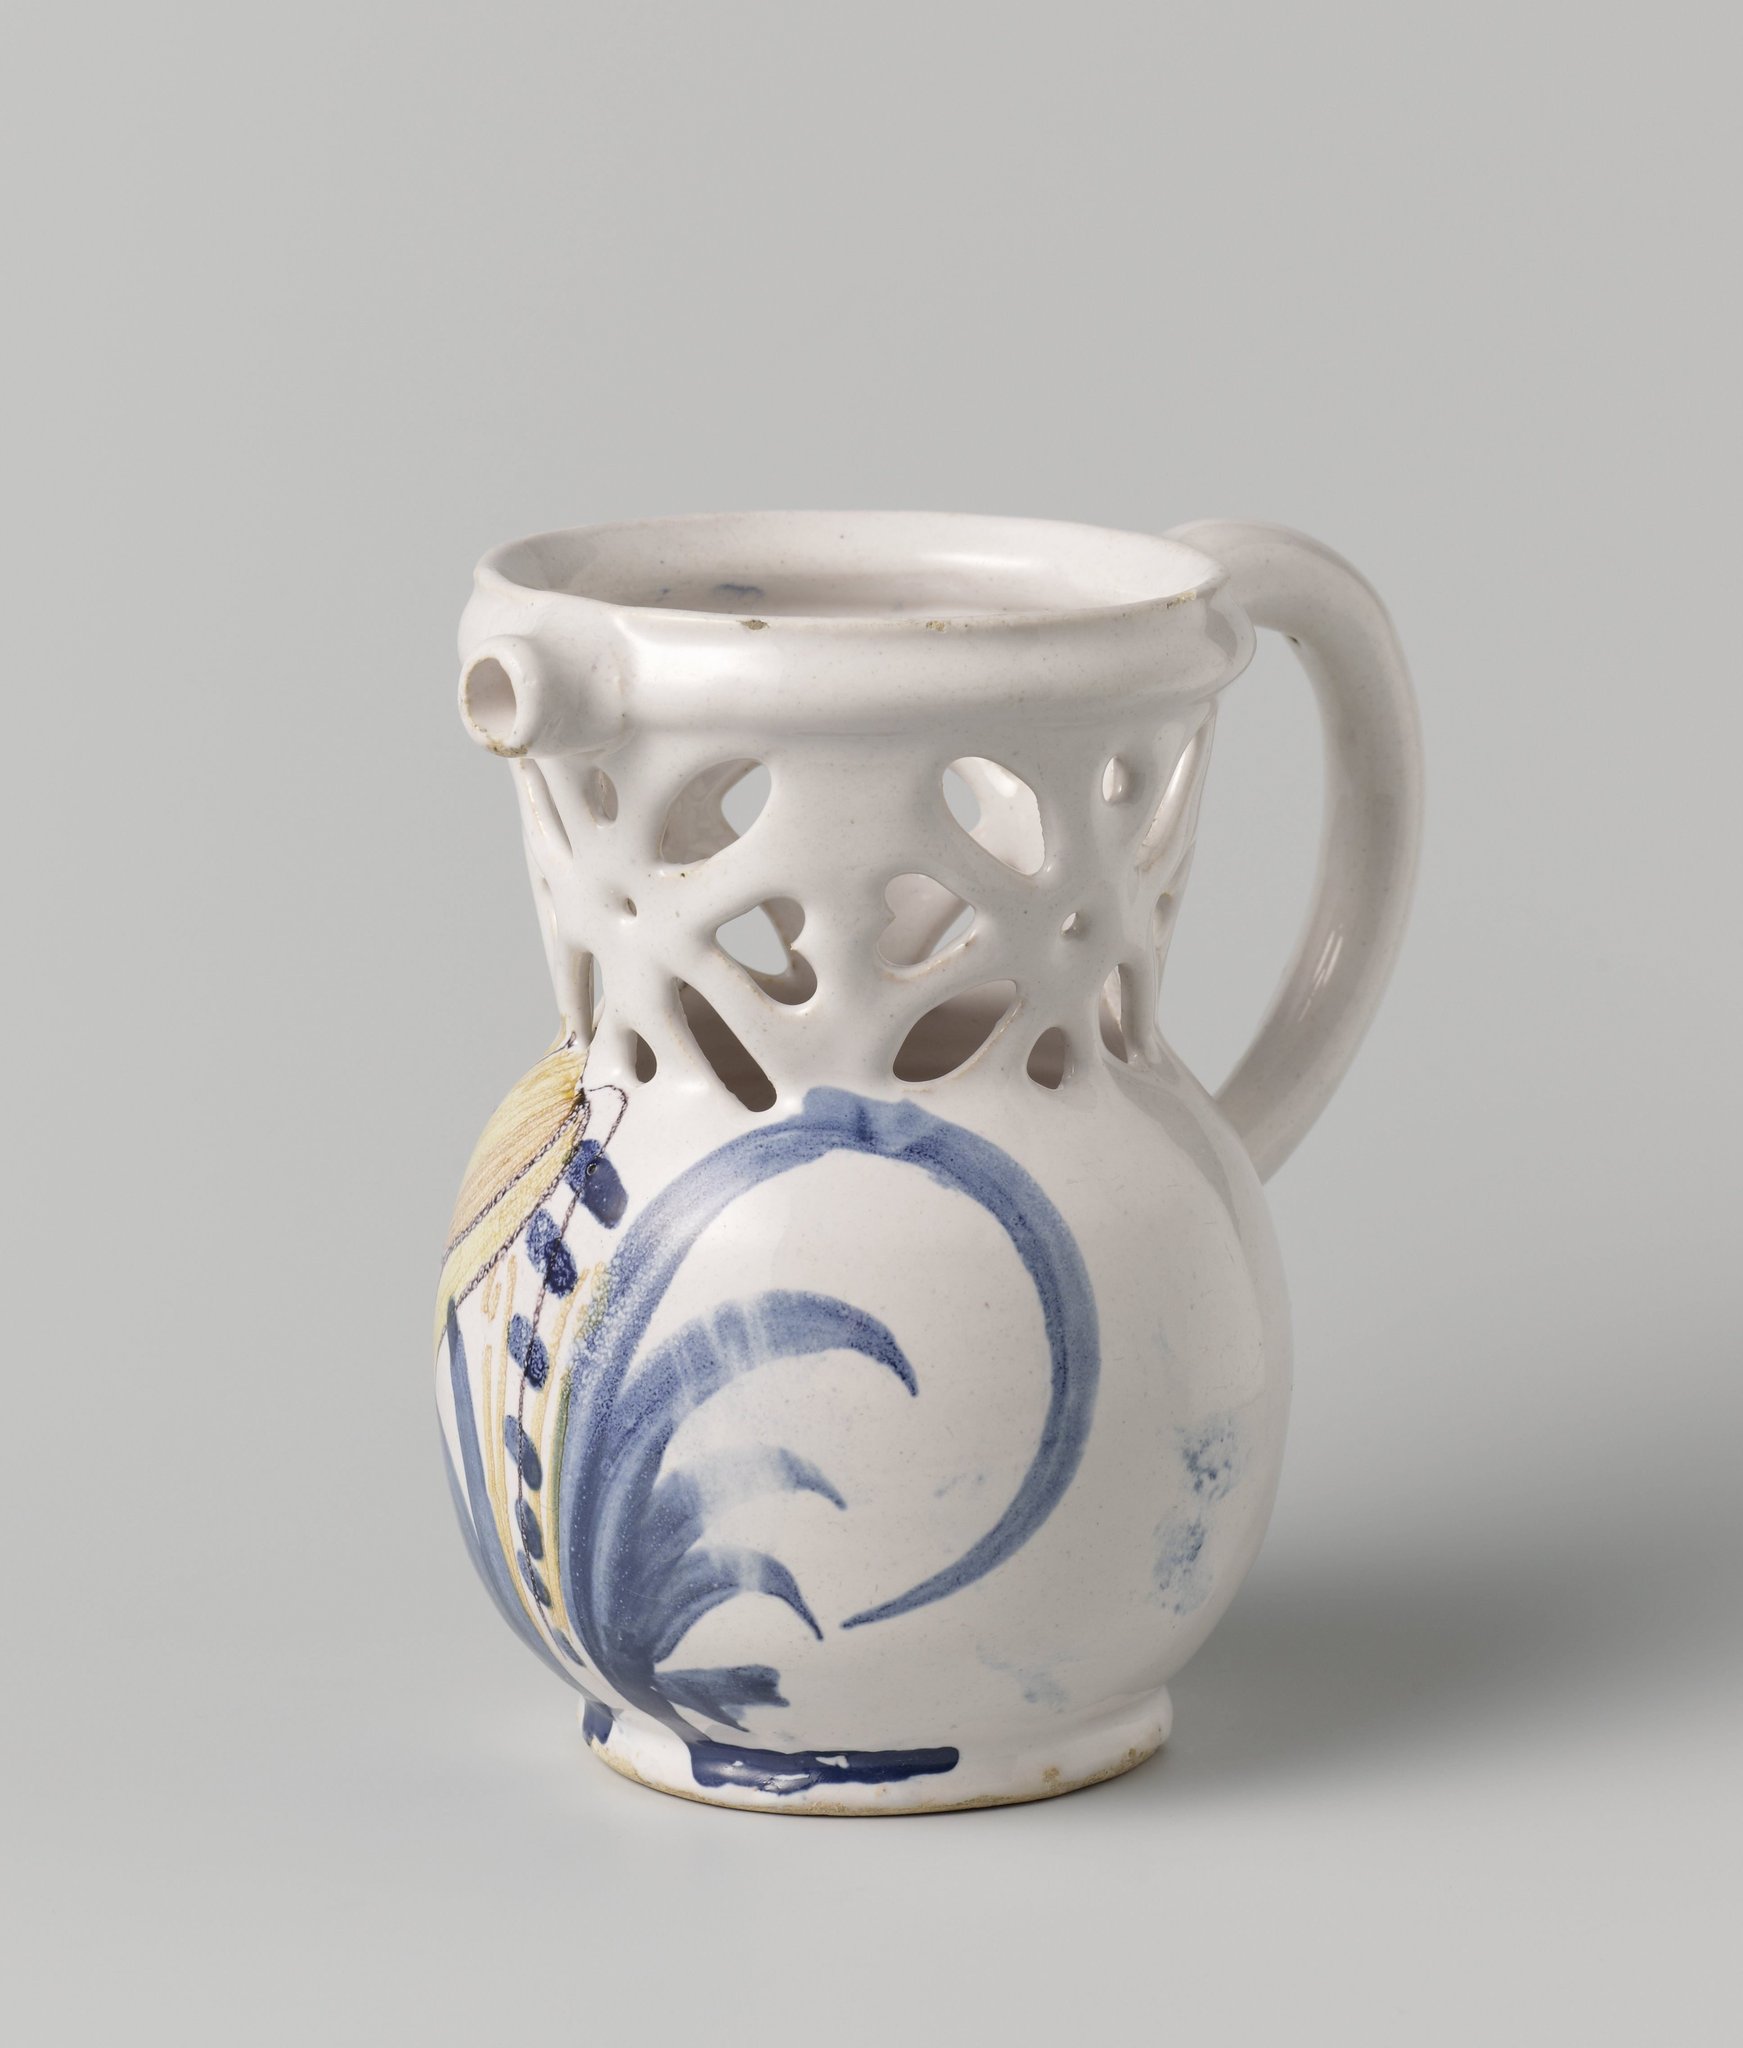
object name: puzzle jug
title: Fopkan, beschilderd met een tulp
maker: Anonymous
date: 1650-1670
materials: earthenware, glaze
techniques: painted, polychromy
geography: delft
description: Fopkan van veelkleurig beschilderde faience. Op de kan is een bloem geschilderd (tulp). De kan heeft een oor en een schenktuit.